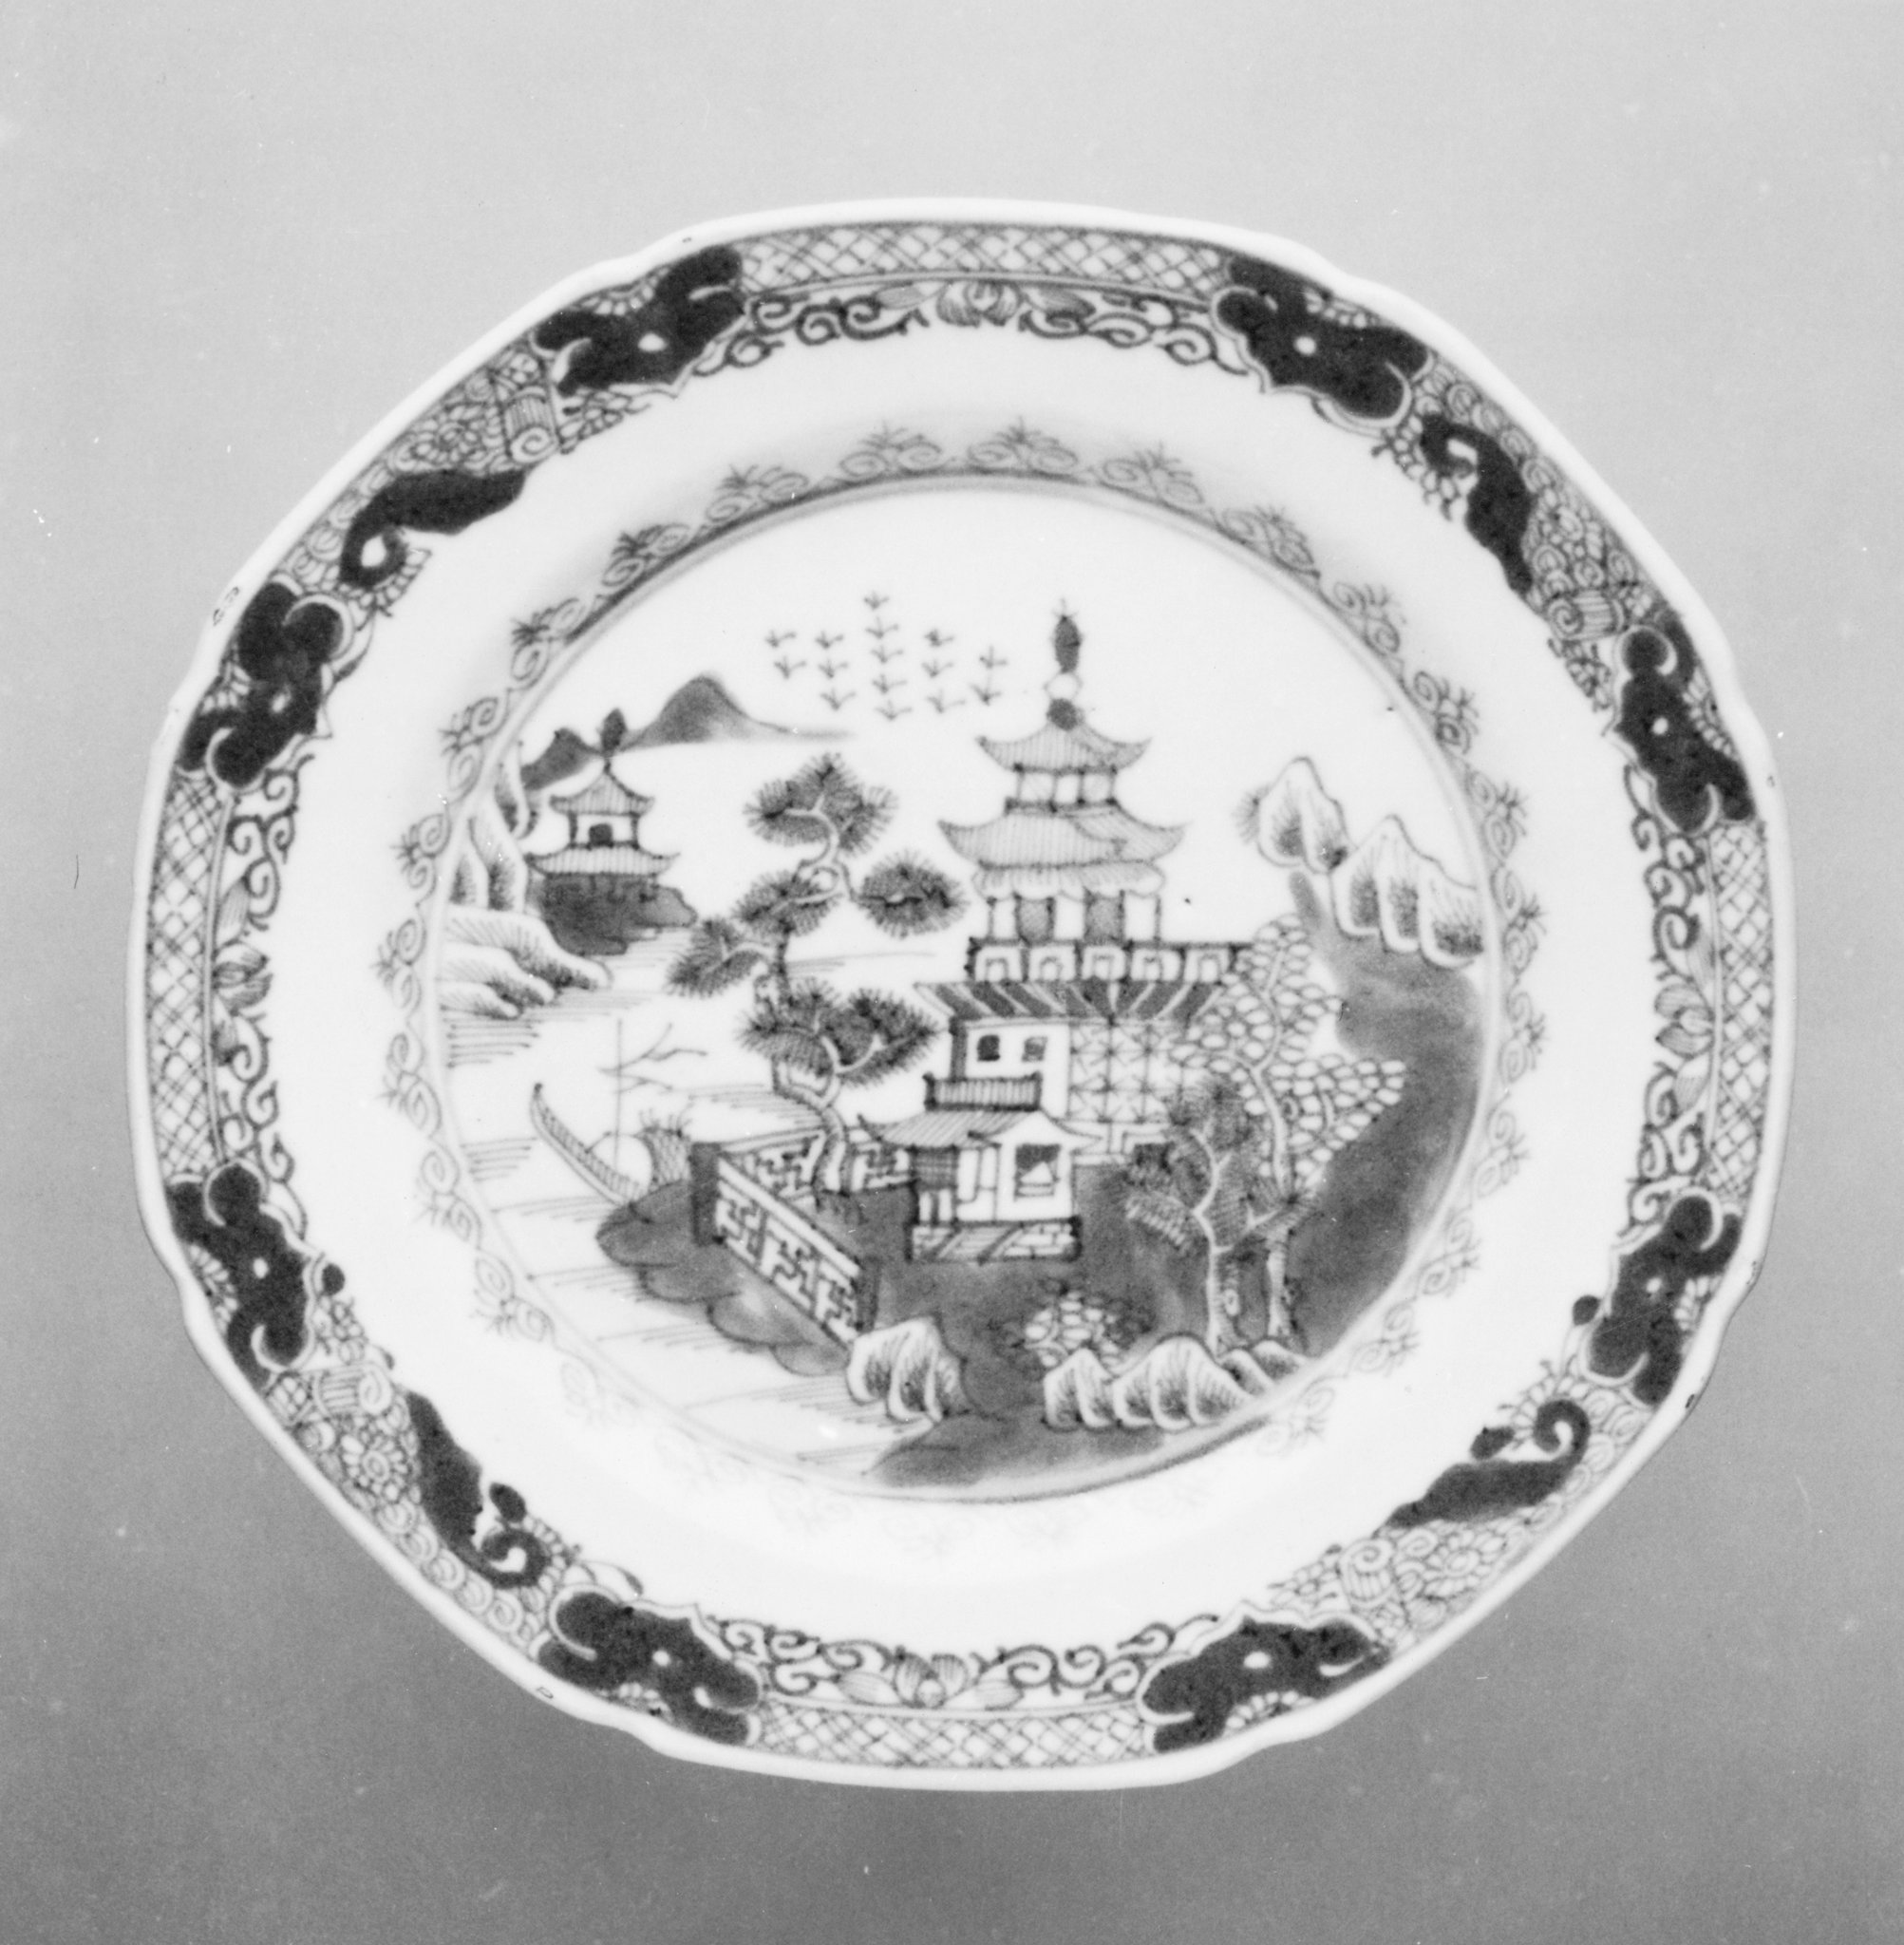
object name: plate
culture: chinese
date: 1501-1900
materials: porcelain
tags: houses,trees